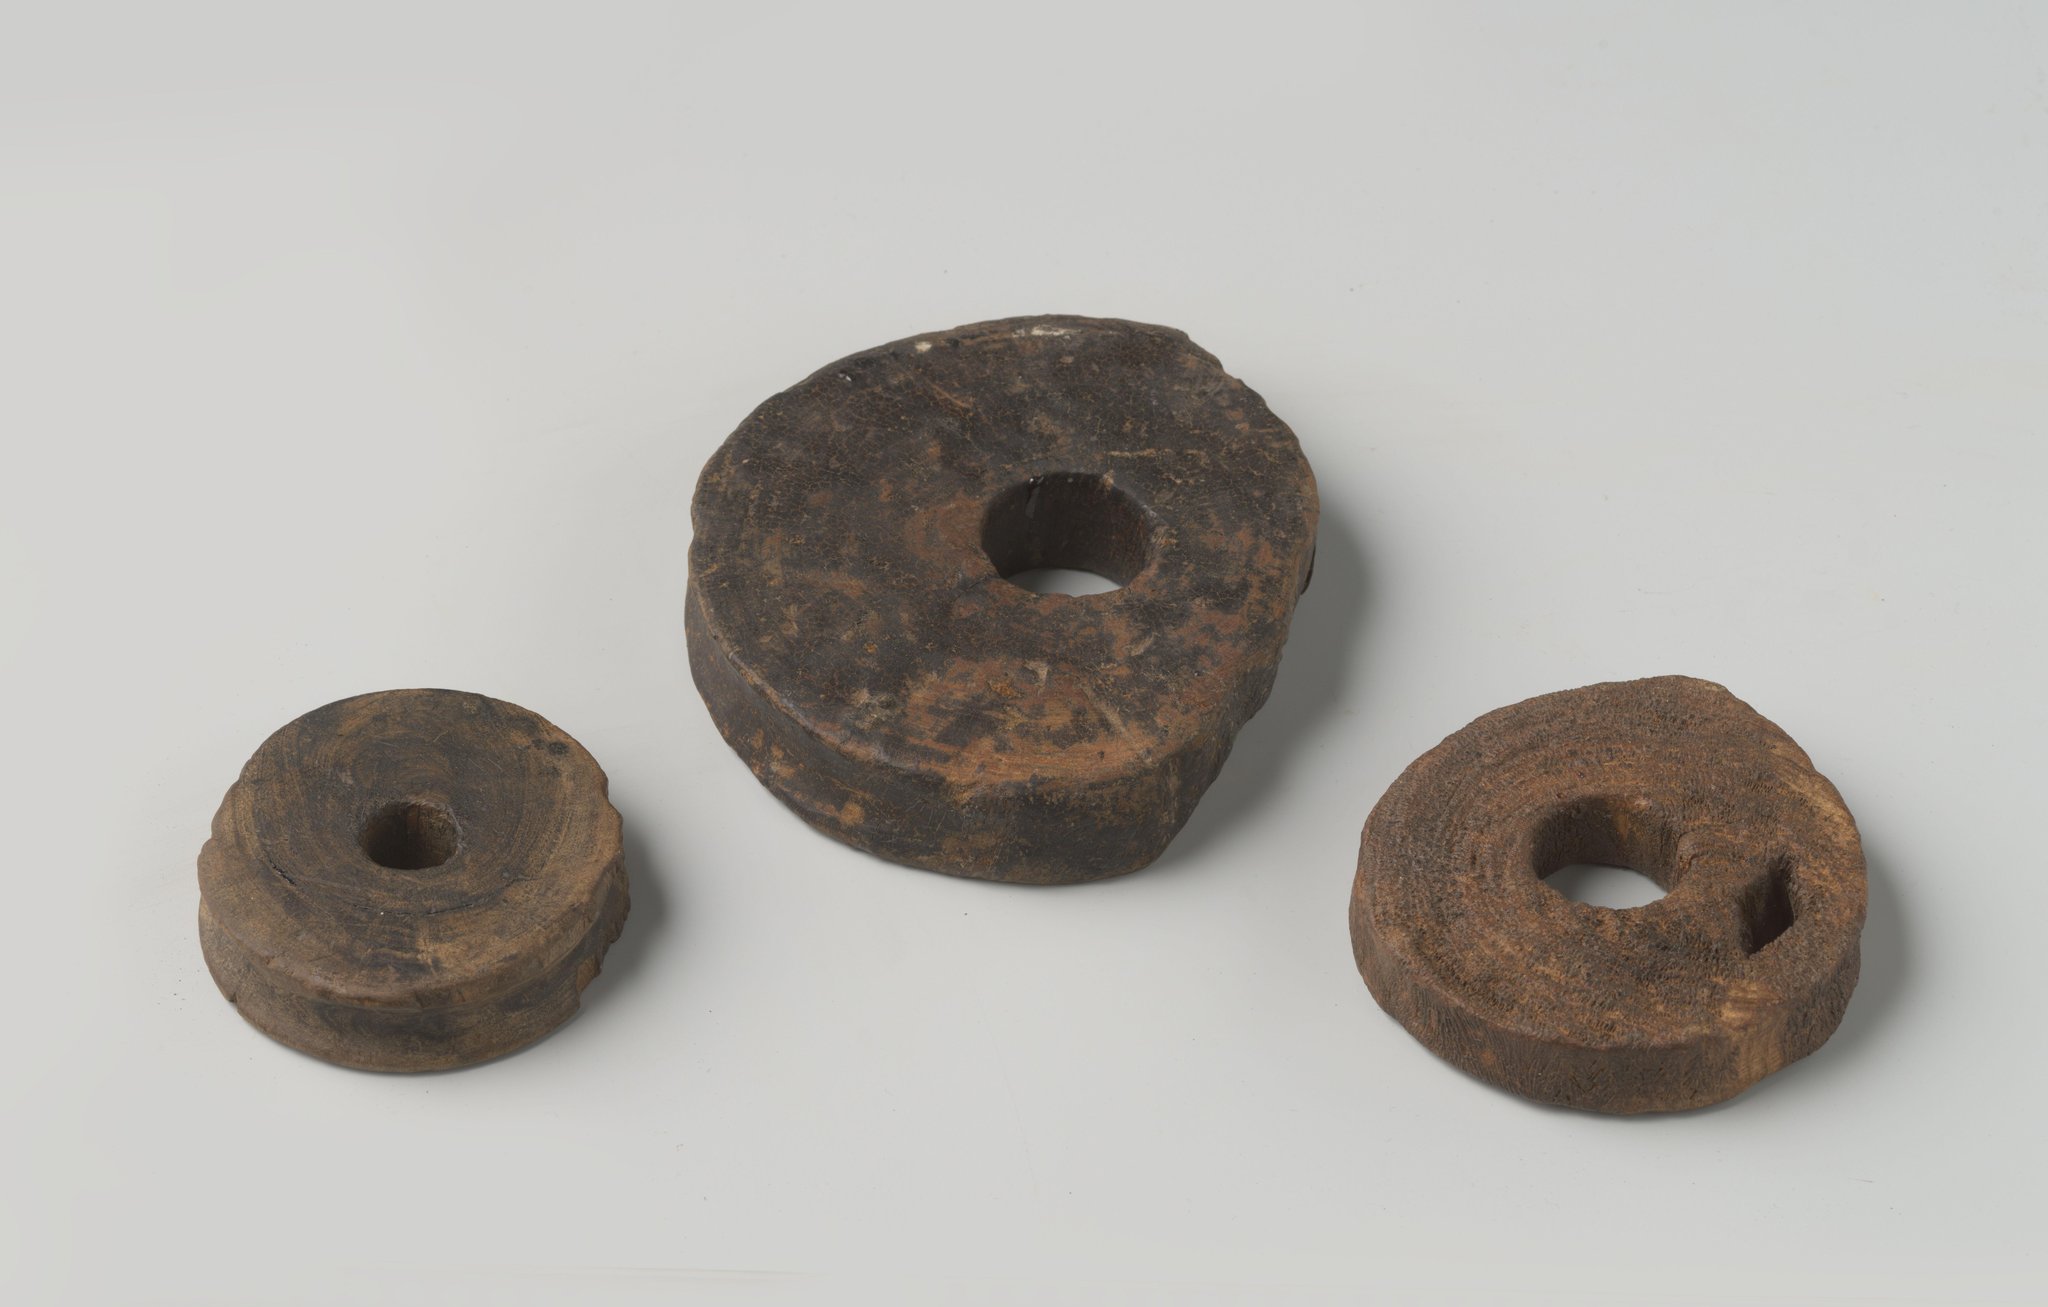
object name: block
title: Schijven uit het wrak van de Oostindiëvaarder Hollandia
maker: Anonymous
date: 1700-1743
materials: wood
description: Twee houten schijven van een takelblok en één van een katrol.